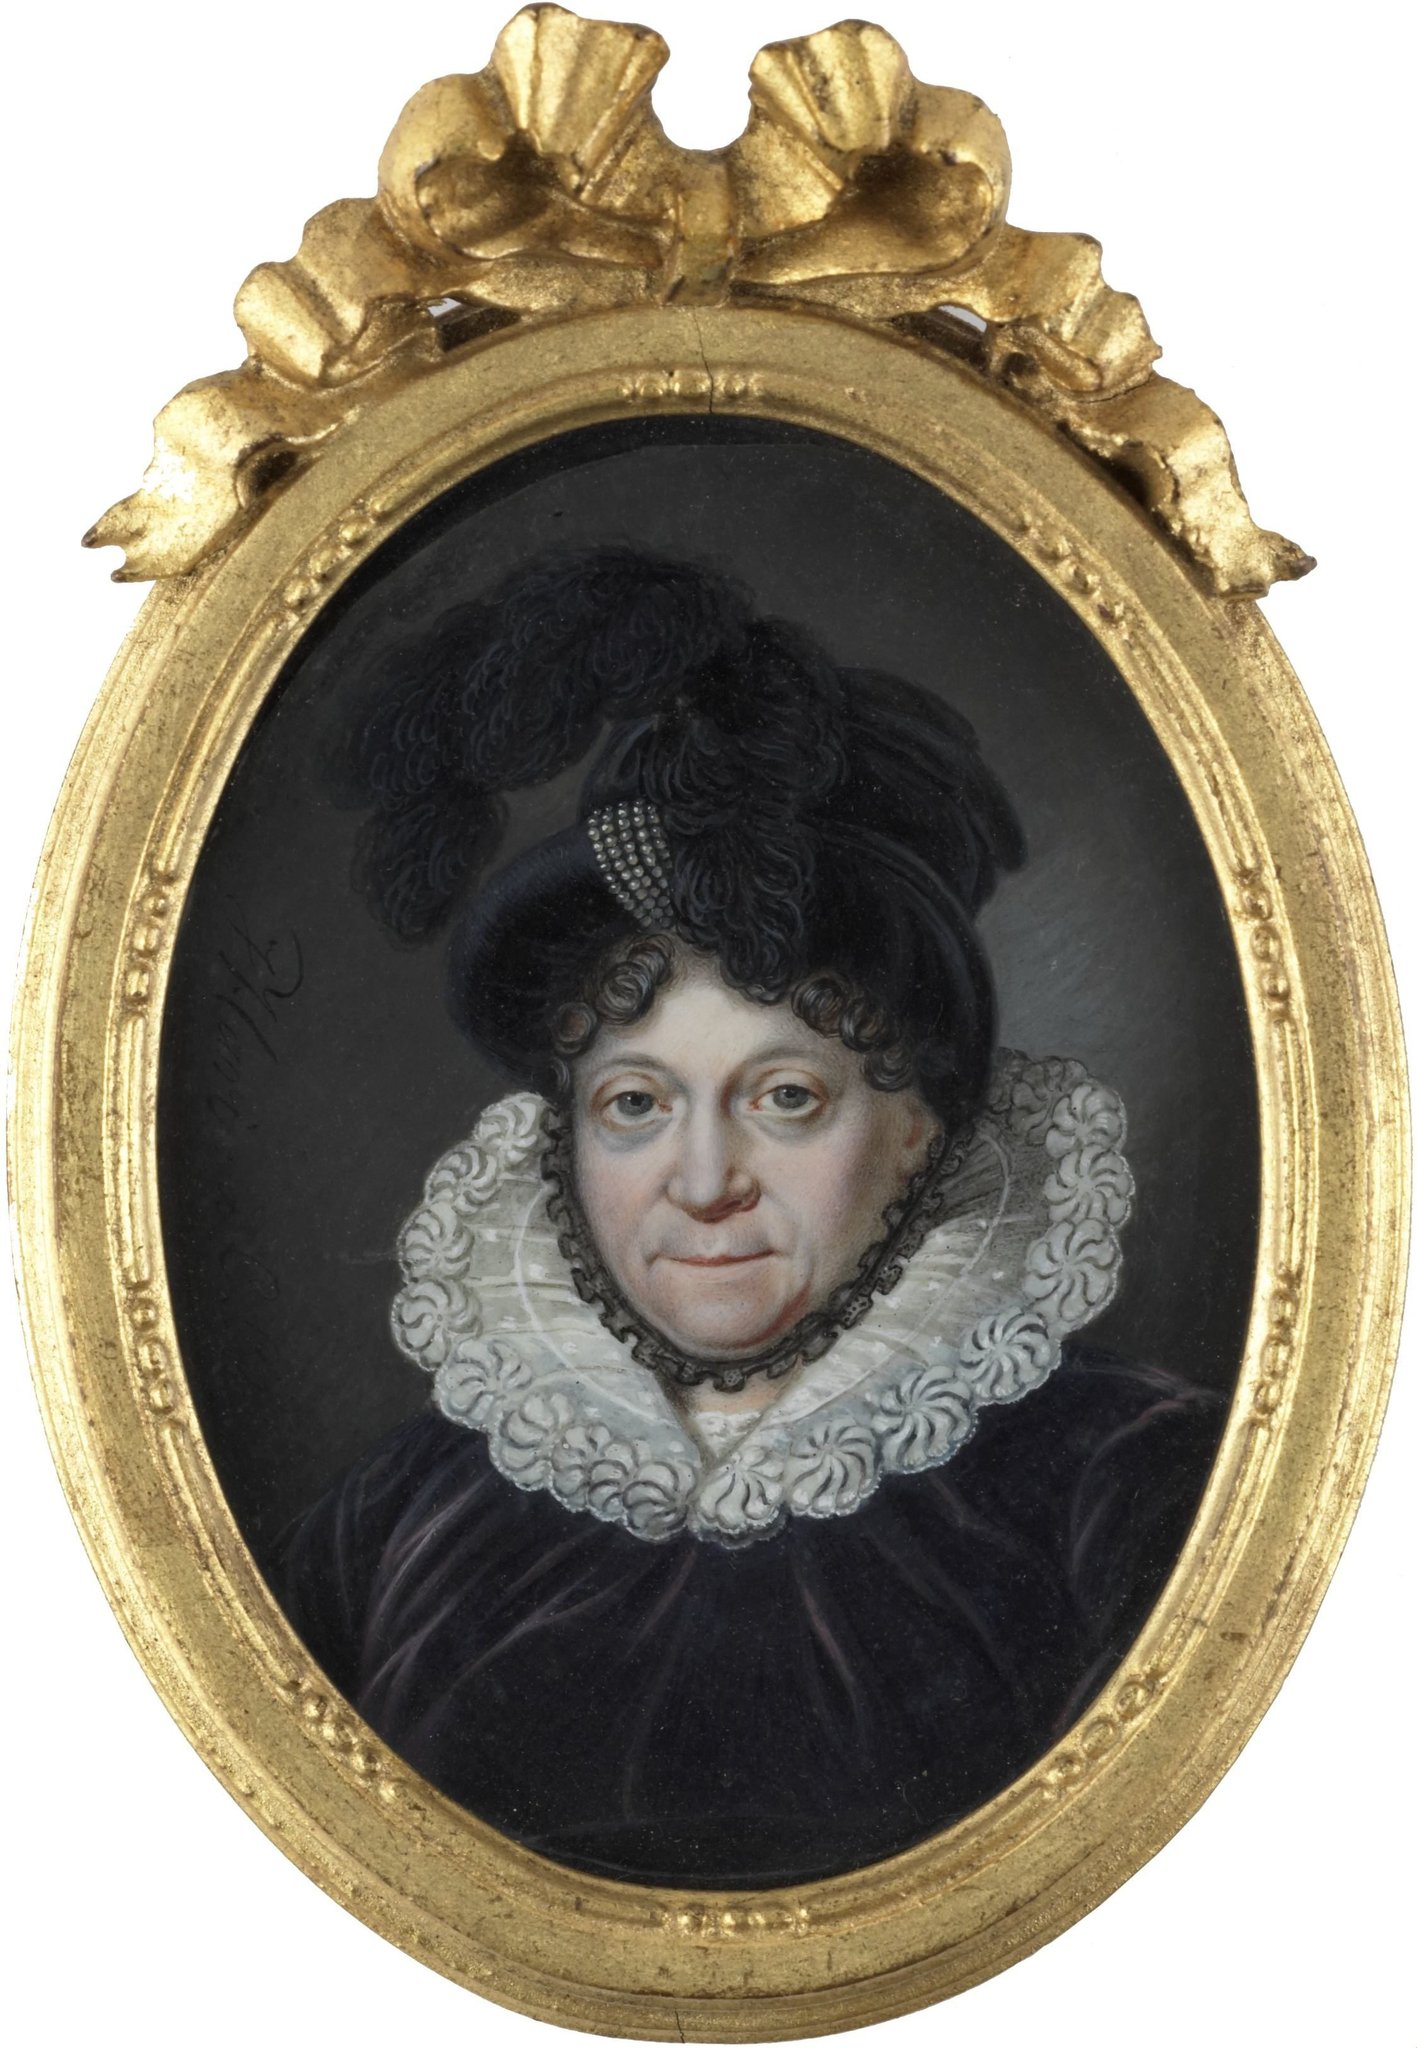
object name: painting, miniature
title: Frederika Sophia Wilhelmina (1751-1820), prinses van Pruisen. Sedert de dood van Willem V Prinses Douairière van Oranje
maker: johannes hari (i)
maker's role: draughtsman, painter, print maker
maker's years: 1772-1849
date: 1817-1820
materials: glass, ivory, leather, wood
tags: berlin, painter, draughtsman, wilhelmina of prussia (princess of orange), historical persons - bb - woman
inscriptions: signature: ‘J. Hari na C. Cels’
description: Portret van Frederika Sophia Wilhelmina (1751-1820), prinses van Pruisen. Sedert de dood van Willem V in 1806 Prinses Douairière van Oranje. Buste, aanziend, met zwarte hoed. Naar een origineel door Cornelis Cels uit 1817 in de Stichting Historische Verzamelingen van het Huis Oranje-Nassau. Onderdeel van de collectie portretminiaturen.